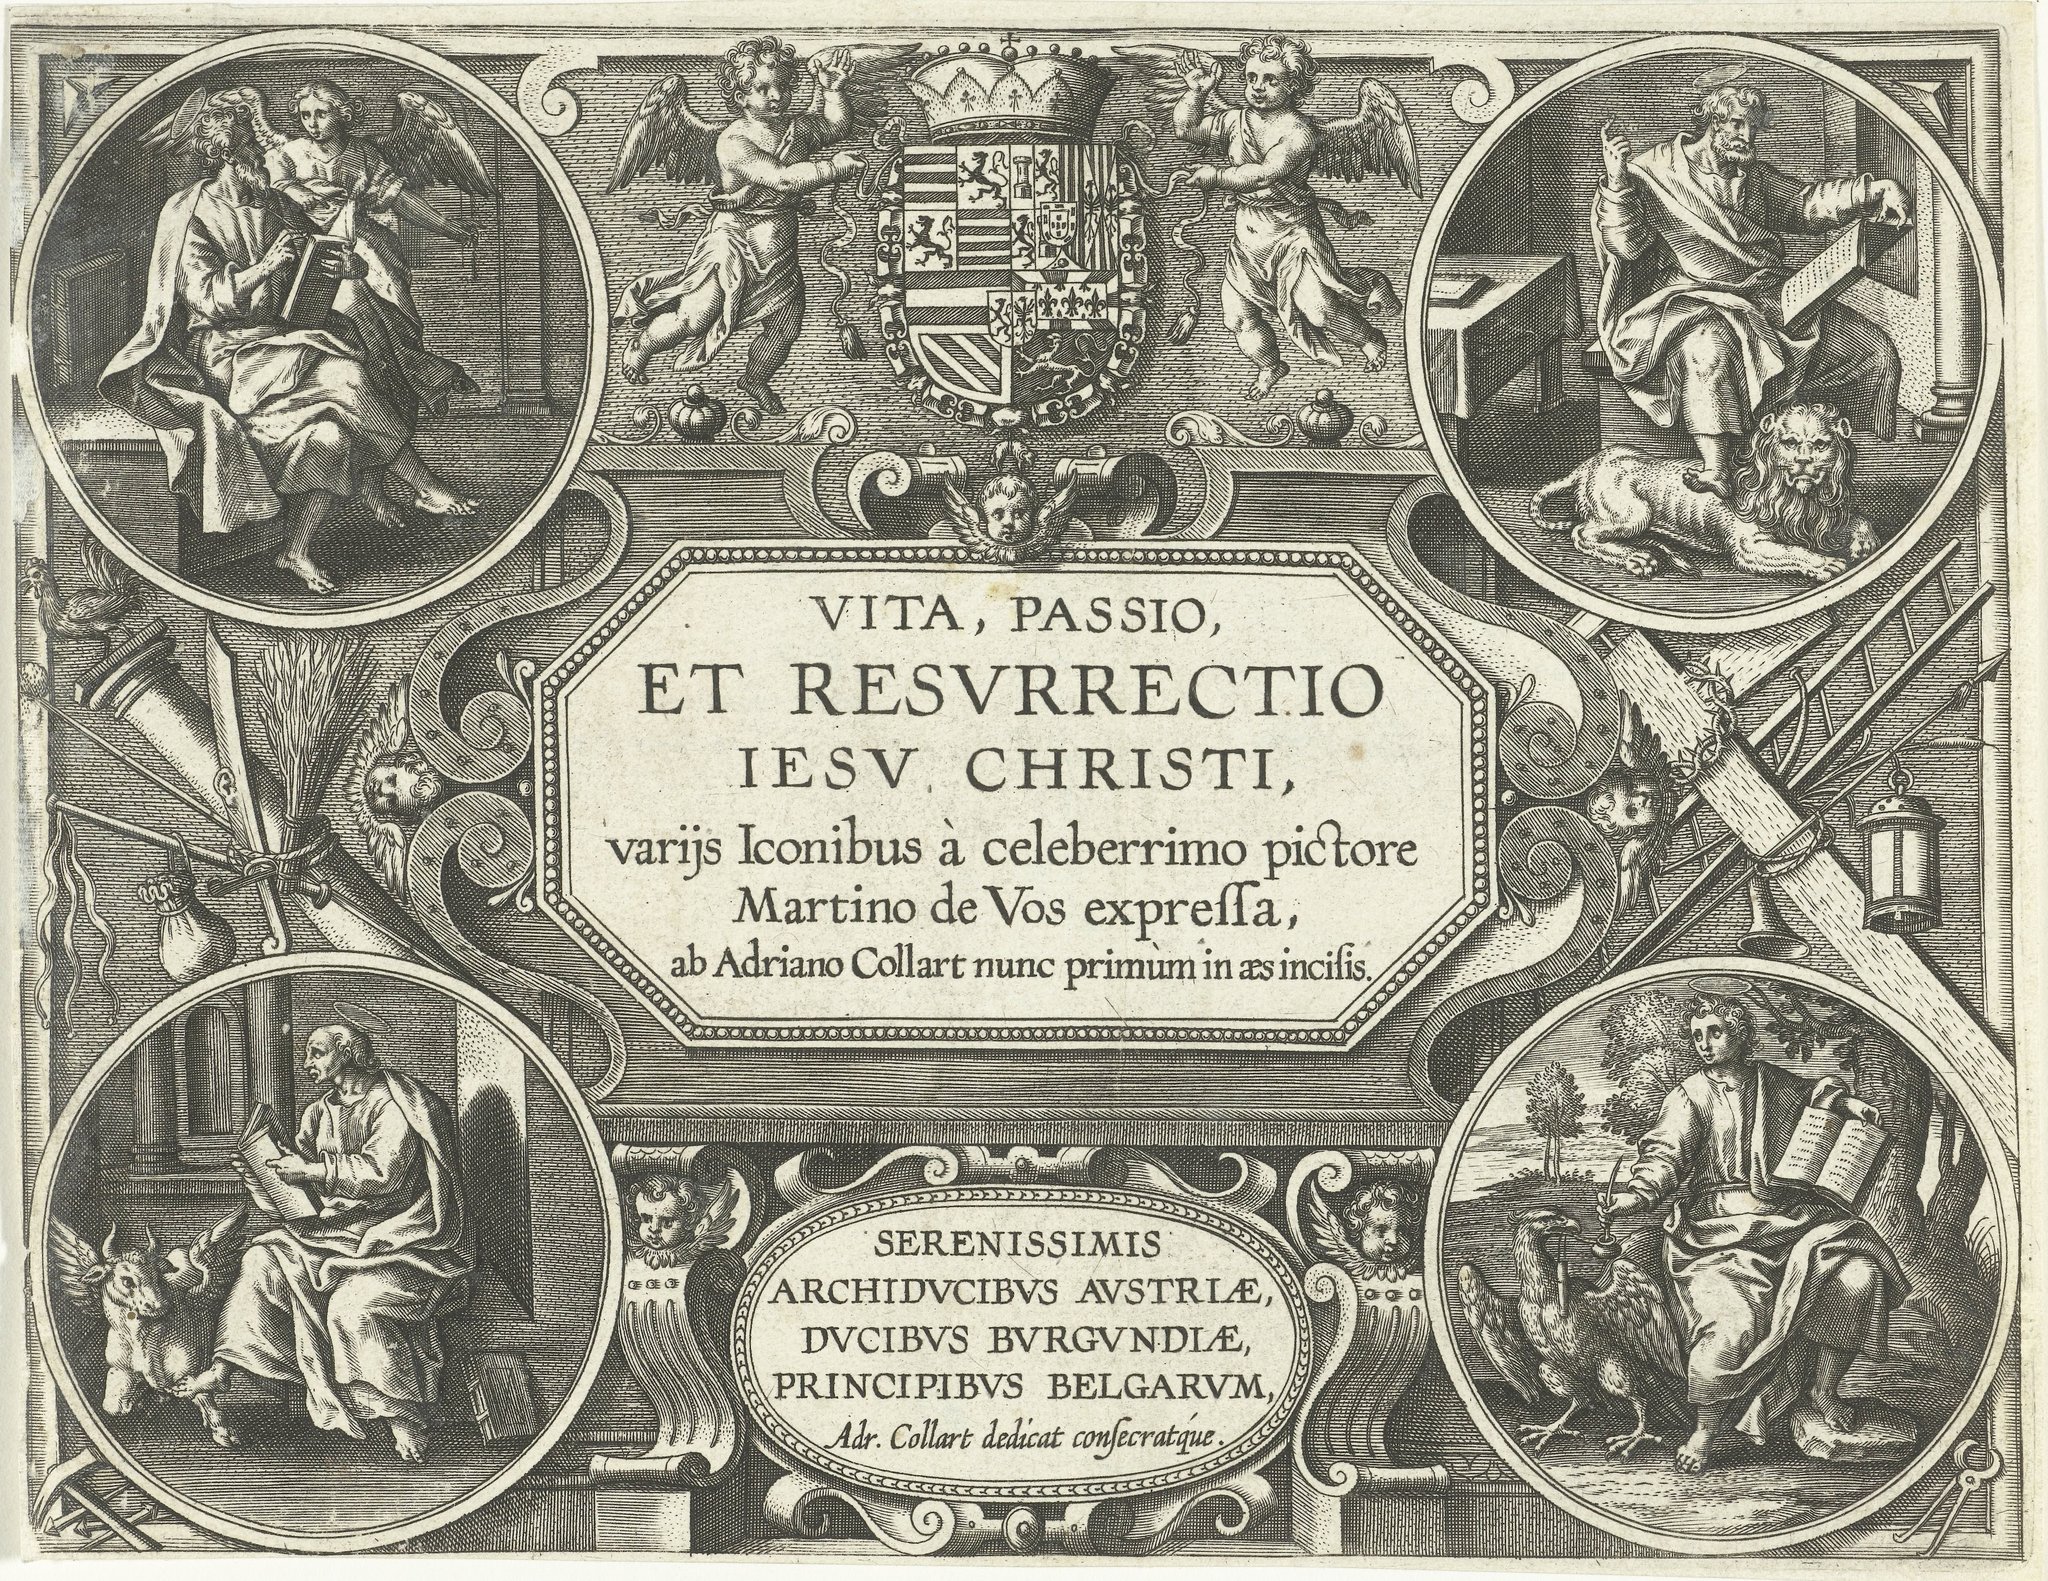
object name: titelprent, frontispice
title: Leven, passie en wederopstanding van Christus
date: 1598-1618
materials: paper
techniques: engraving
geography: antwerp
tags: infante van spanje isabella clara eugenia, brussels, albrecht aartshertog van oostenrijk, evangelists, usually with books or scrolls (not in biblical context), single instruments of the passion, title-page, the four symbols of the evangelists, 'the apocalyptic beasts', armorial bearing, heraldry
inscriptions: collector's mark: Lugt 2228, inscription: ‘In dit werkje zijn de pl. van de volgende meesters: A. Collaert (15 stuks); Joan Collaert (6 stuks), Jan de Bye(17 stuks), Corn. Galle (7 stuks), J. Barbé (6 stuks)’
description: In een octagonale lijst de titel van de serie. Daarboven houden twee putti het wapenschild van aartshertogen Albrecht en Isabella omhoog. Onder de titel een cartouche met een dedicatie. Naast de titel de werktuigen van de passie. In de vier hoeken van de prent een ronde afbeelding met een van de vier evangelisten. De prent maakt deel uit van een serie over het leven van Christus.